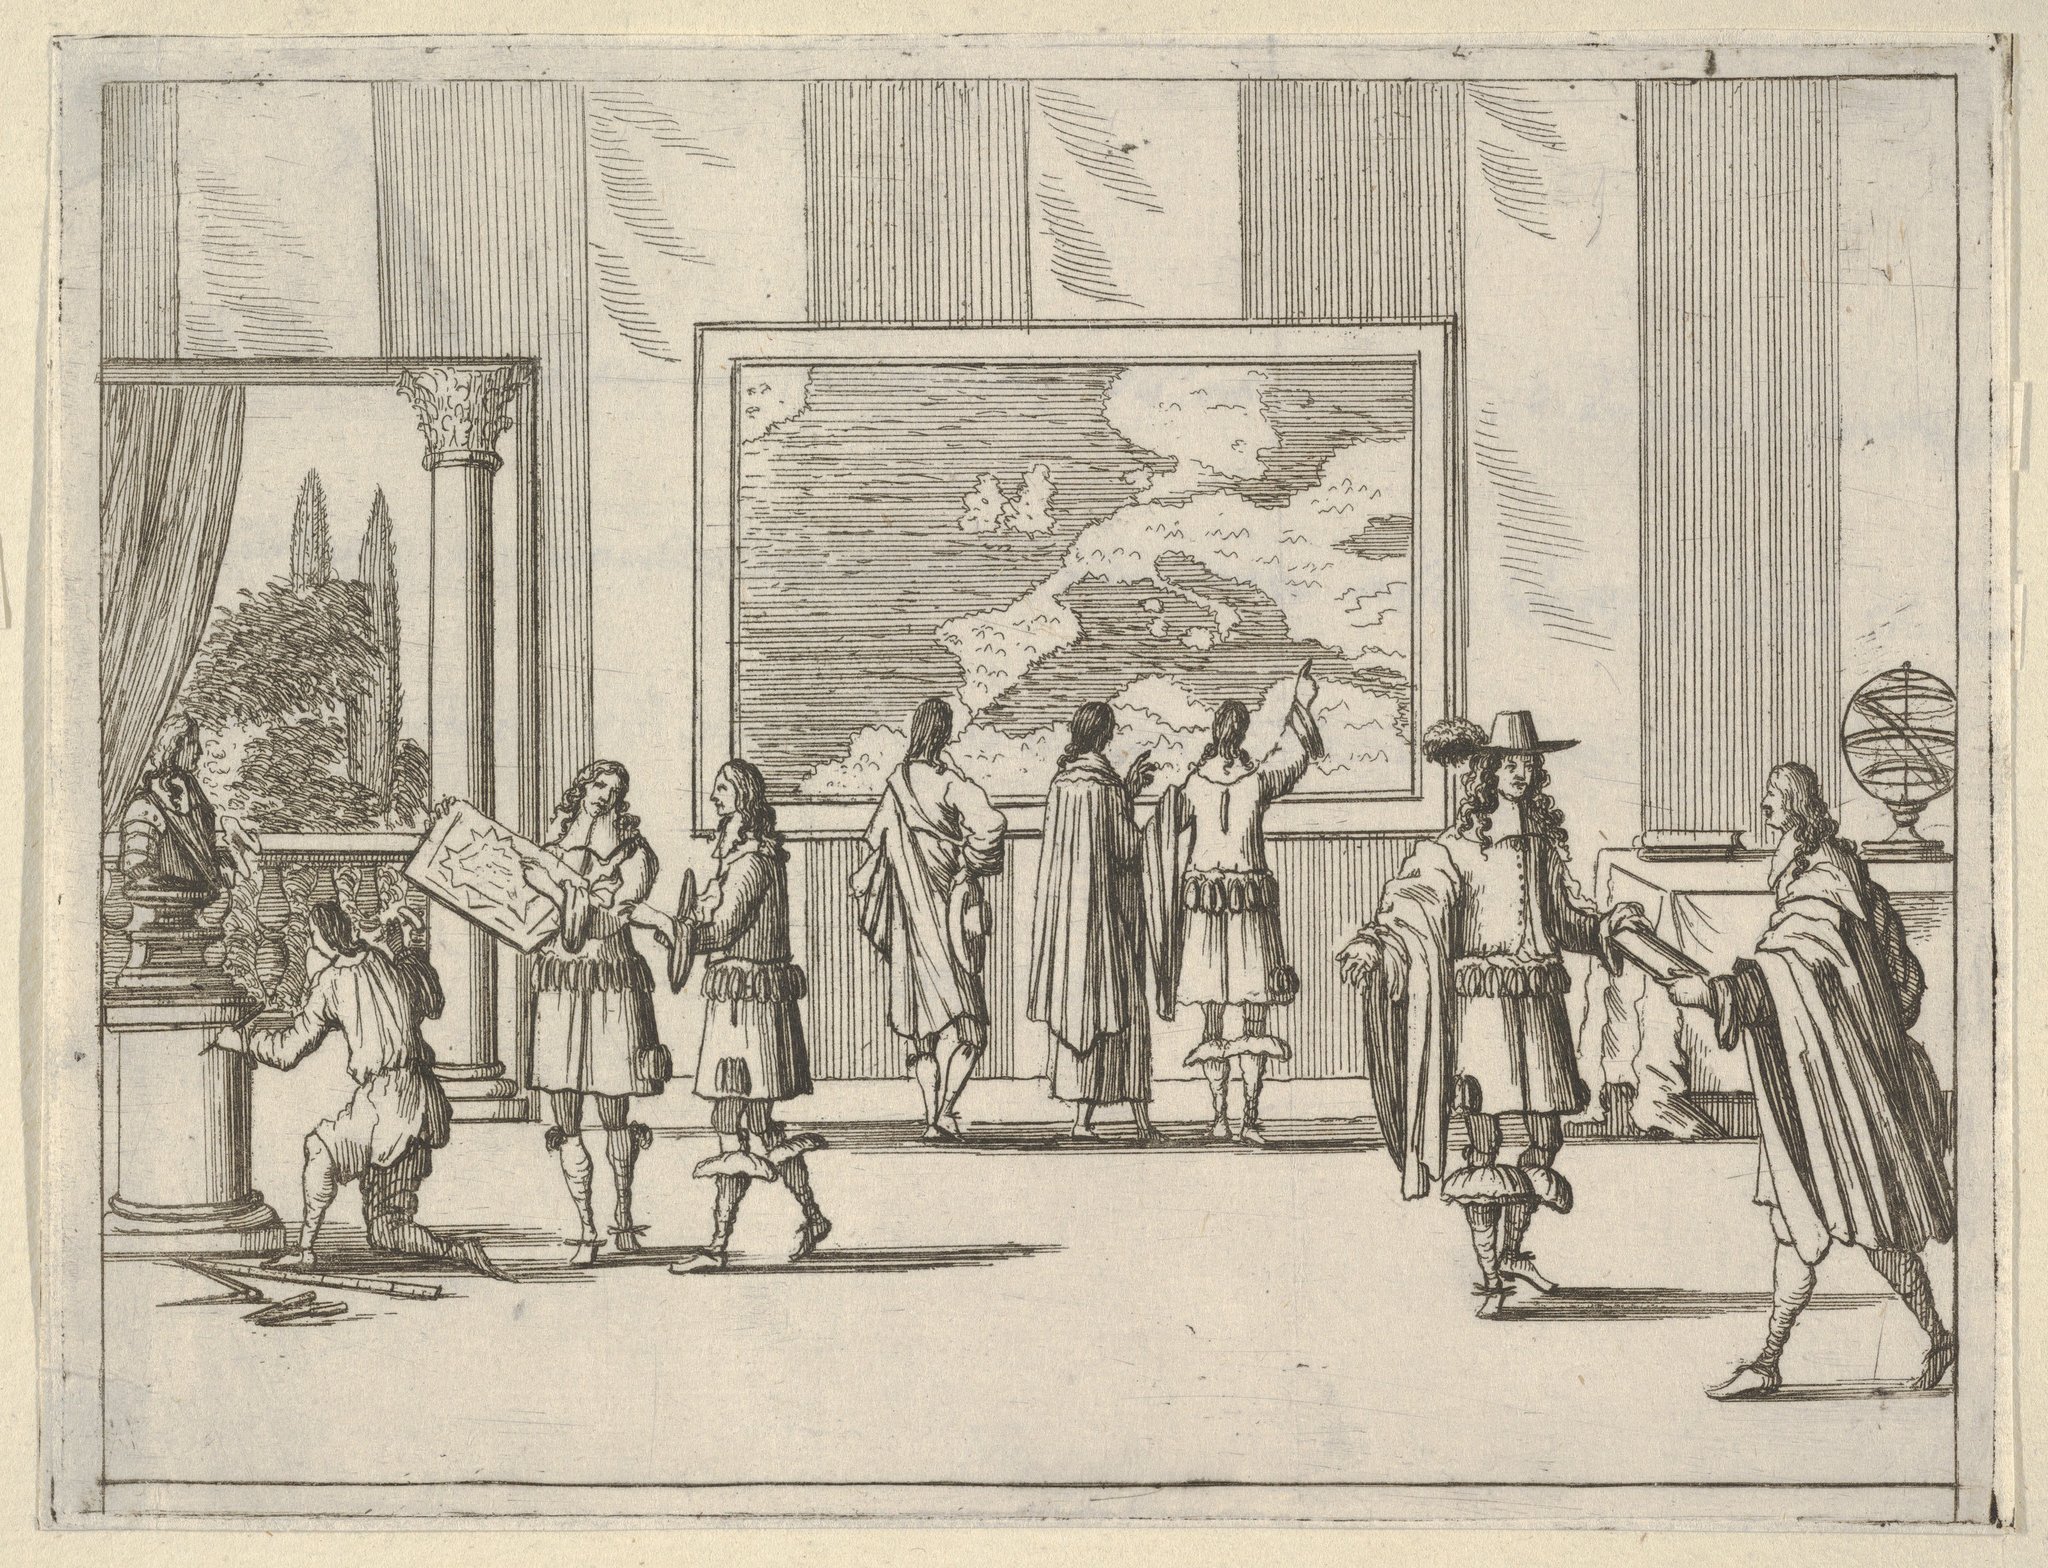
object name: print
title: Francesco I d'Este Invites Foreign Scholars to Court, from "L'Idea di un Principe ed Eroe Cristiano in Francesco I d'Este, di Modena e Reggio Duca VIII [...]"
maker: bartolomeo fenice (fénis)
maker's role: artist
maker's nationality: italian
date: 1659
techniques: etching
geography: italy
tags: men,maps